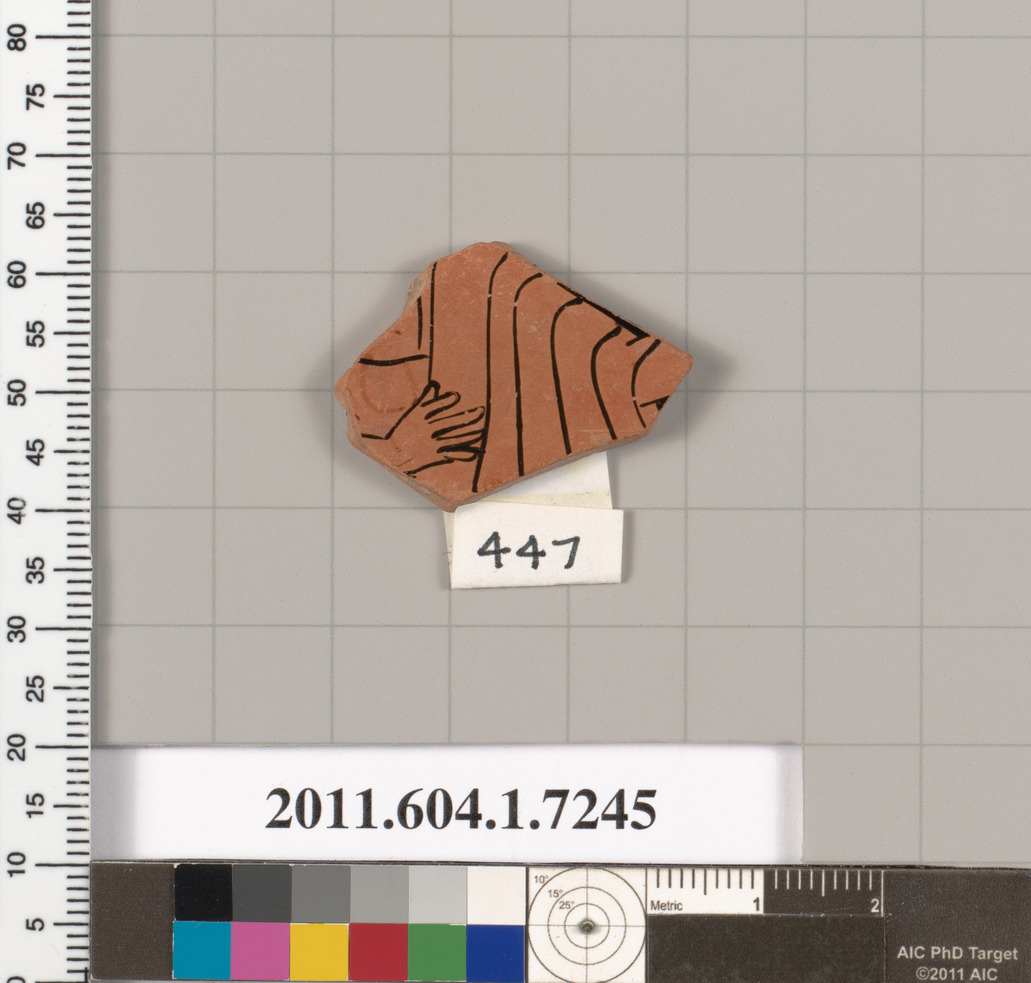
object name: kylix fragment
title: Terracotta fragment of a kylix (drinking cup)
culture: greek, attic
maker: makron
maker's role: artist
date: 500-480 BCE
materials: terracotta